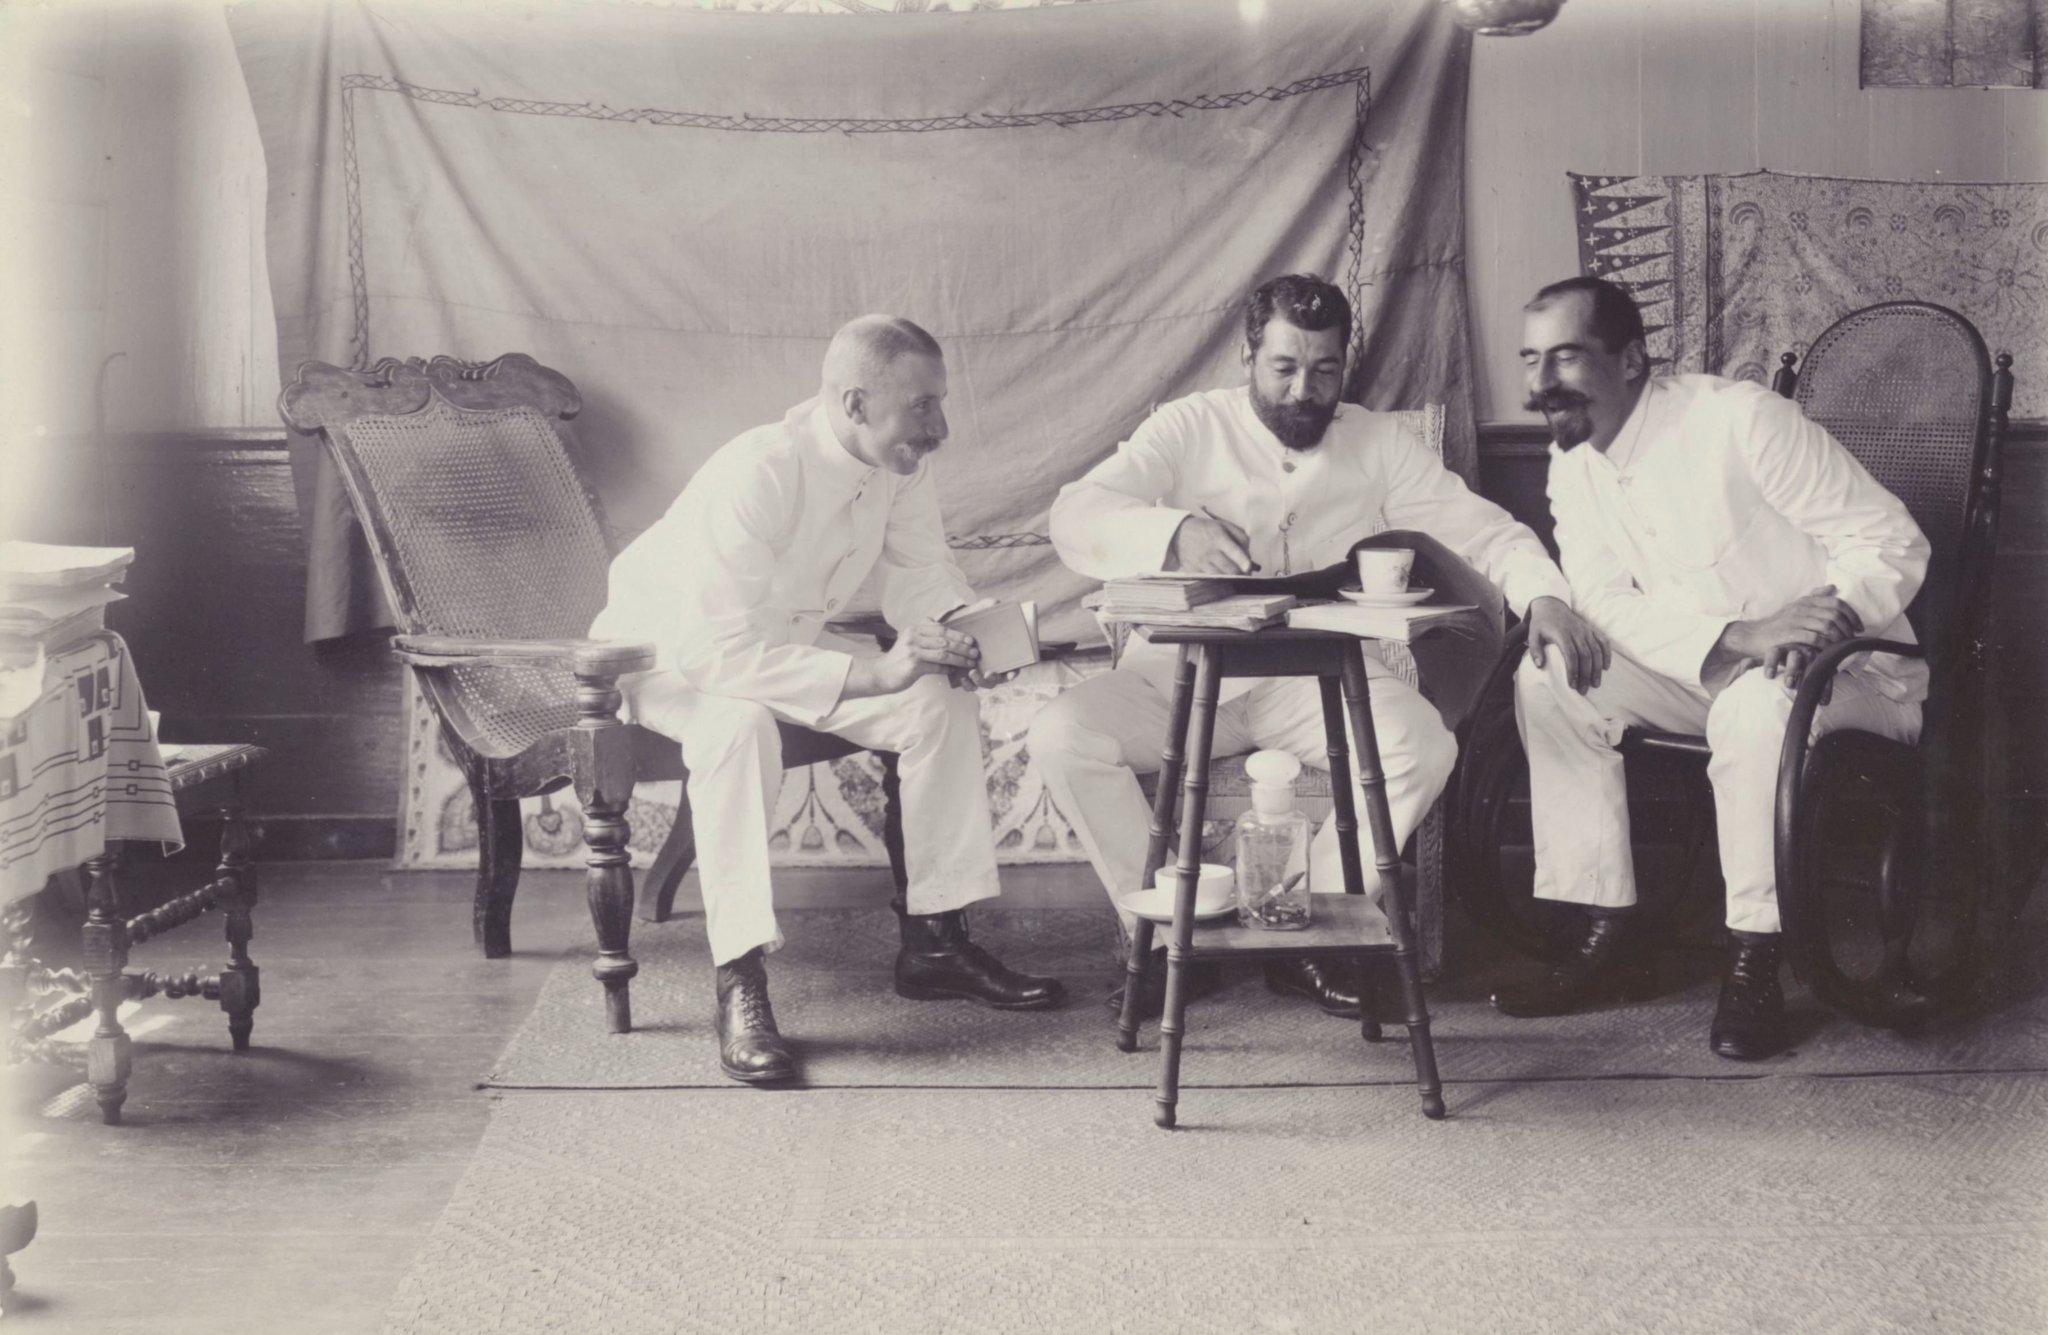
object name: photograph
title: Groepsfoto in de Gravenstraat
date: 1908-1910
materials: photographic support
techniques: photography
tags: amsterdam, andries augustus boom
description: Groepsfoto van Andries Boom, Dr. van Hall en Dhr. van de Werk, in het huis van Van Hall in de Gravenstraat in Paramaribo, oktober 1908. Op de achtergrond bananenbomen. Onderdeel van het fotoalbum van de familie Boom-Gonggrijp in Suriname en Curaçao.